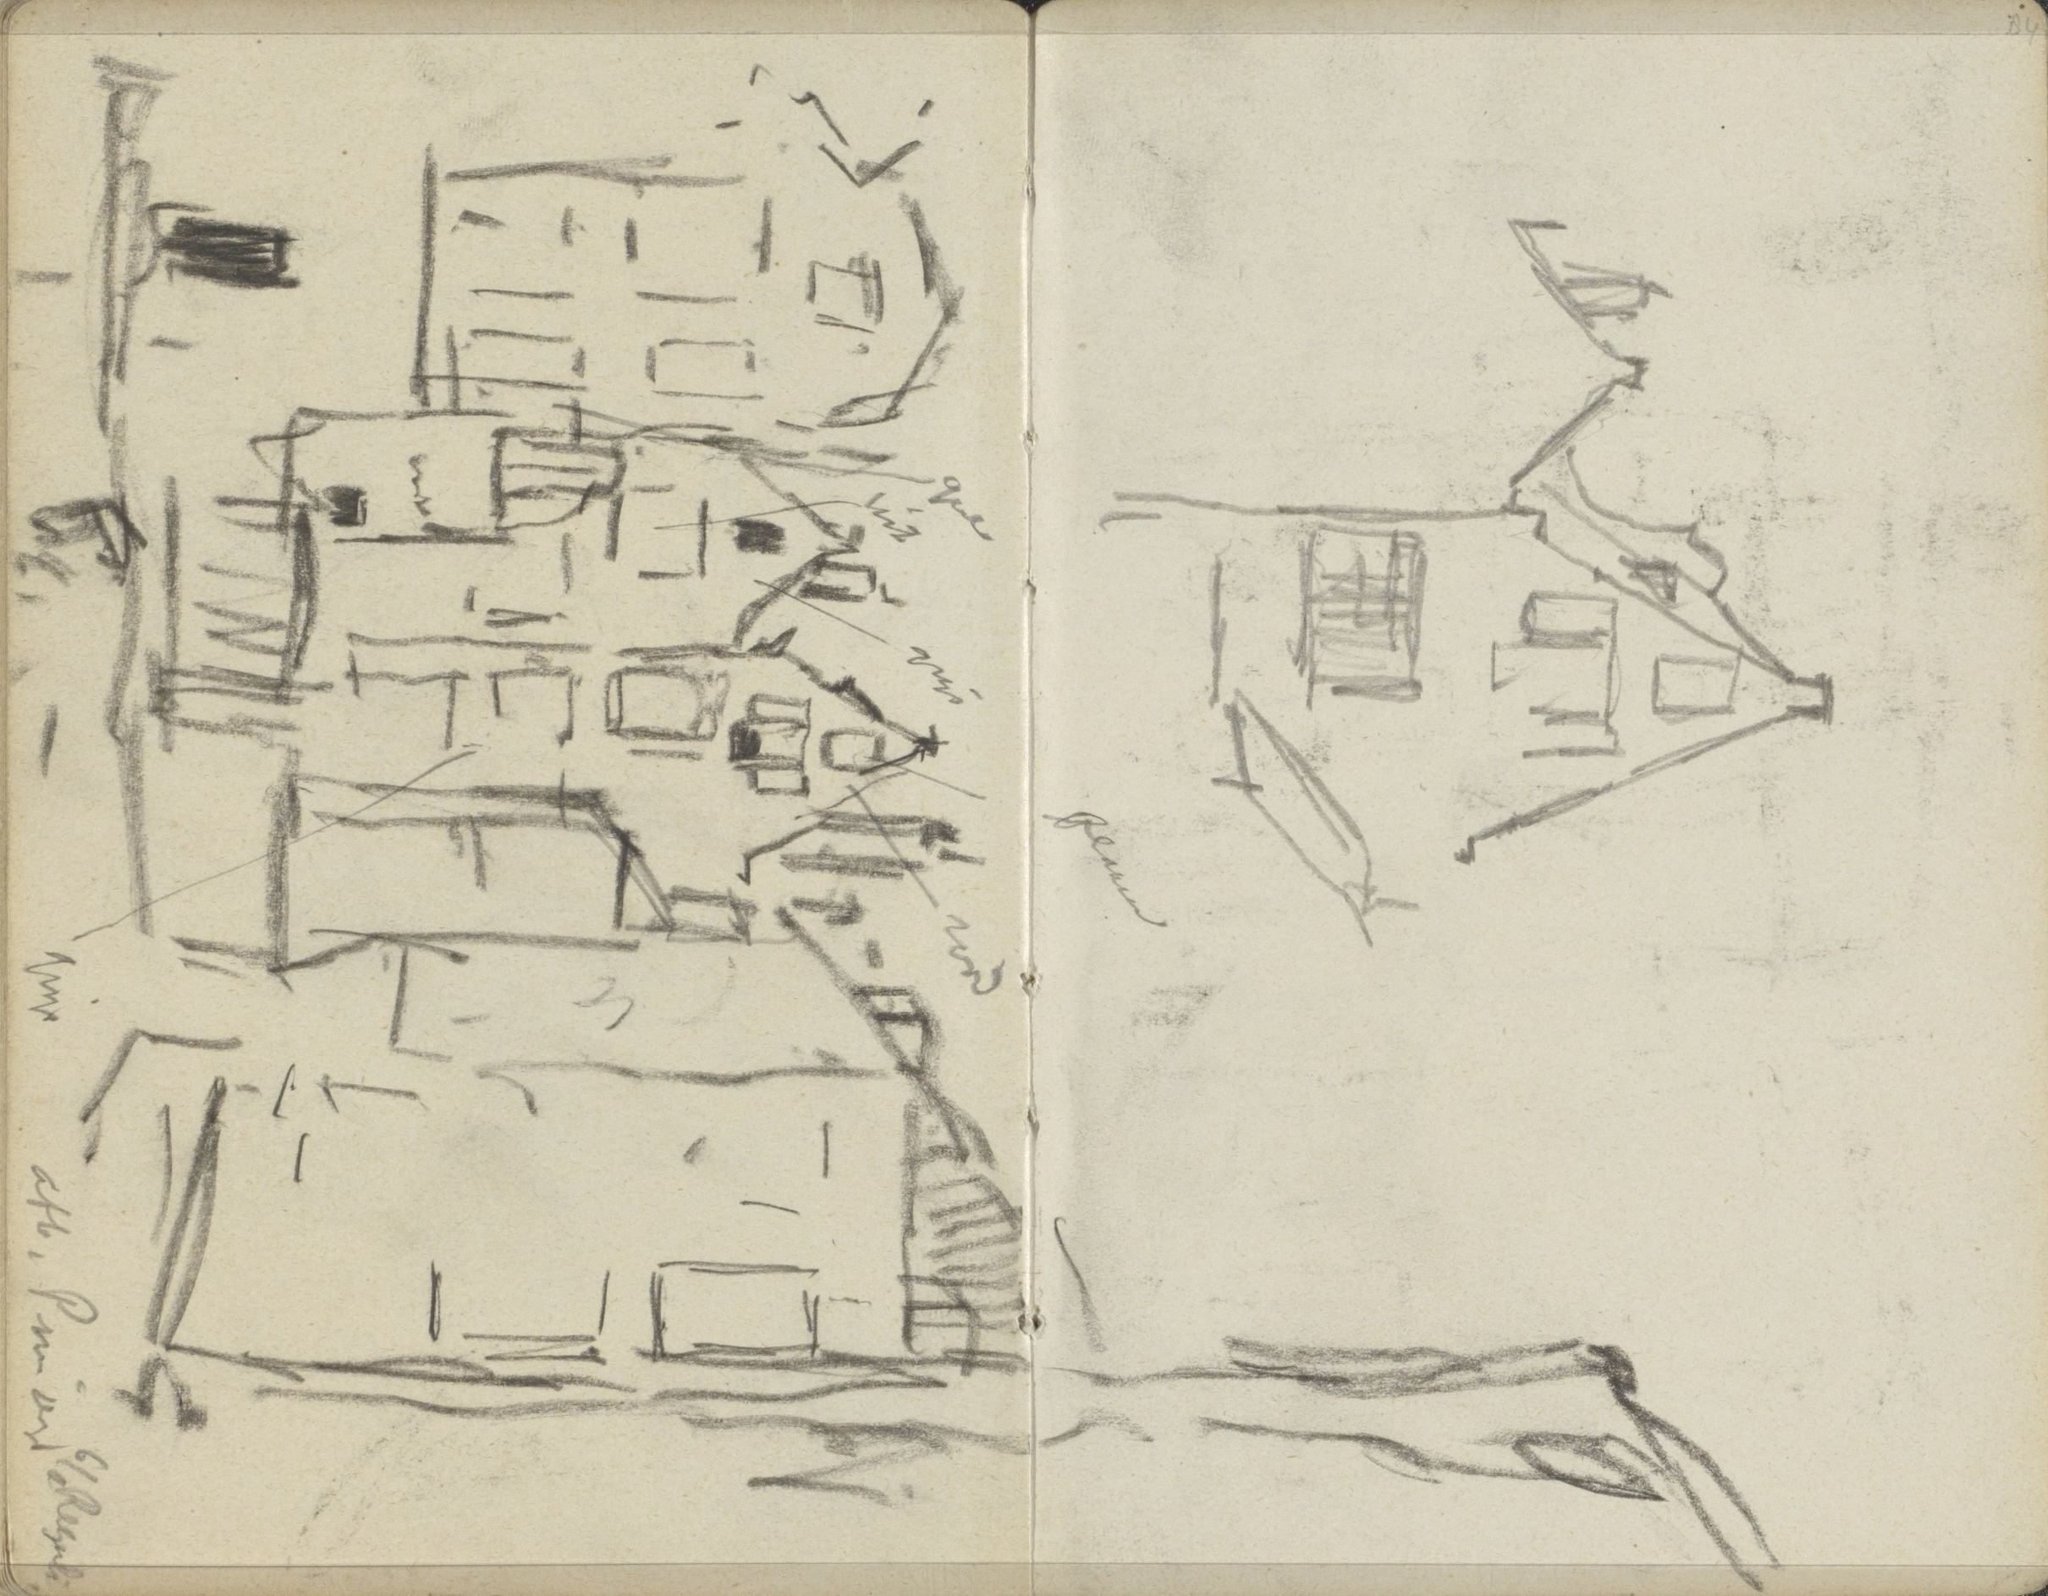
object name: sketchbook leaf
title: Afbraak van de Prinsengracht in Amsterdam ter hoogte van de Reguliersgracht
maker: george hendrik breitner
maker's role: draughtsman, painter, print maker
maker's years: 1857-1923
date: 1910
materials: chalk, paper, pencil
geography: amsterdam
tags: demolition of building, civic architecture; edifices; dwellings, street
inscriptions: annotation: ‘afb. Prinsengr b/d Reguli’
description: Pagina 83 en pagina 84 uit een schetsboek met 45 bladen.